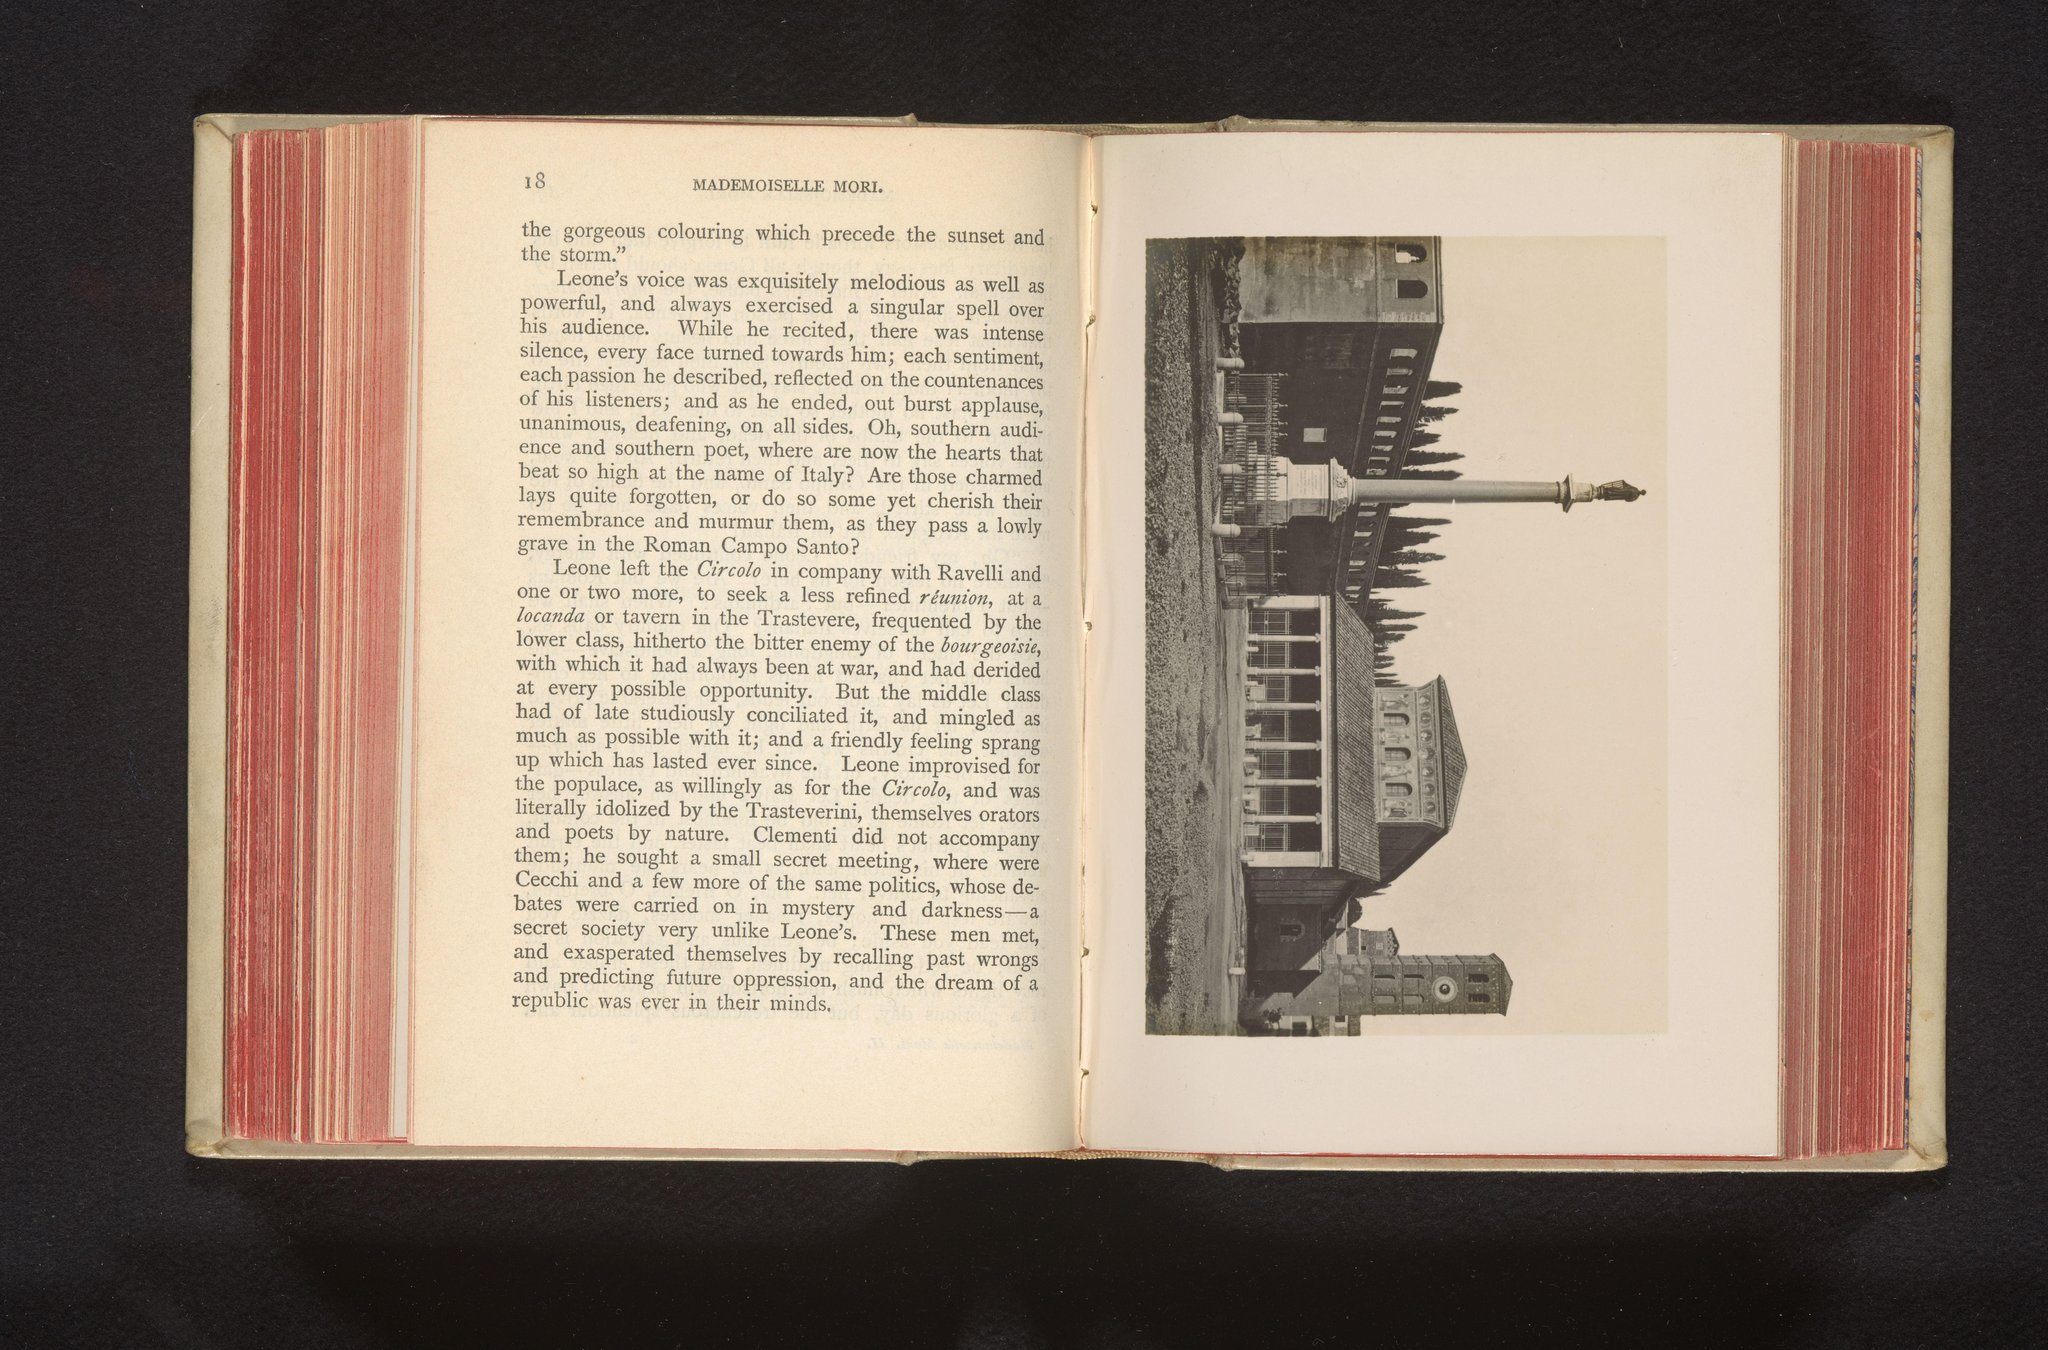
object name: page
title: Voorgevel van de Sint-Laurens buiten de Muren te Rome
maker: Anonymous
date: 1852-1862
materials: photographic support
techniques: gelatin silver print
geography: rome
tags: church (exterior), hôtel, i.e. small palace in city